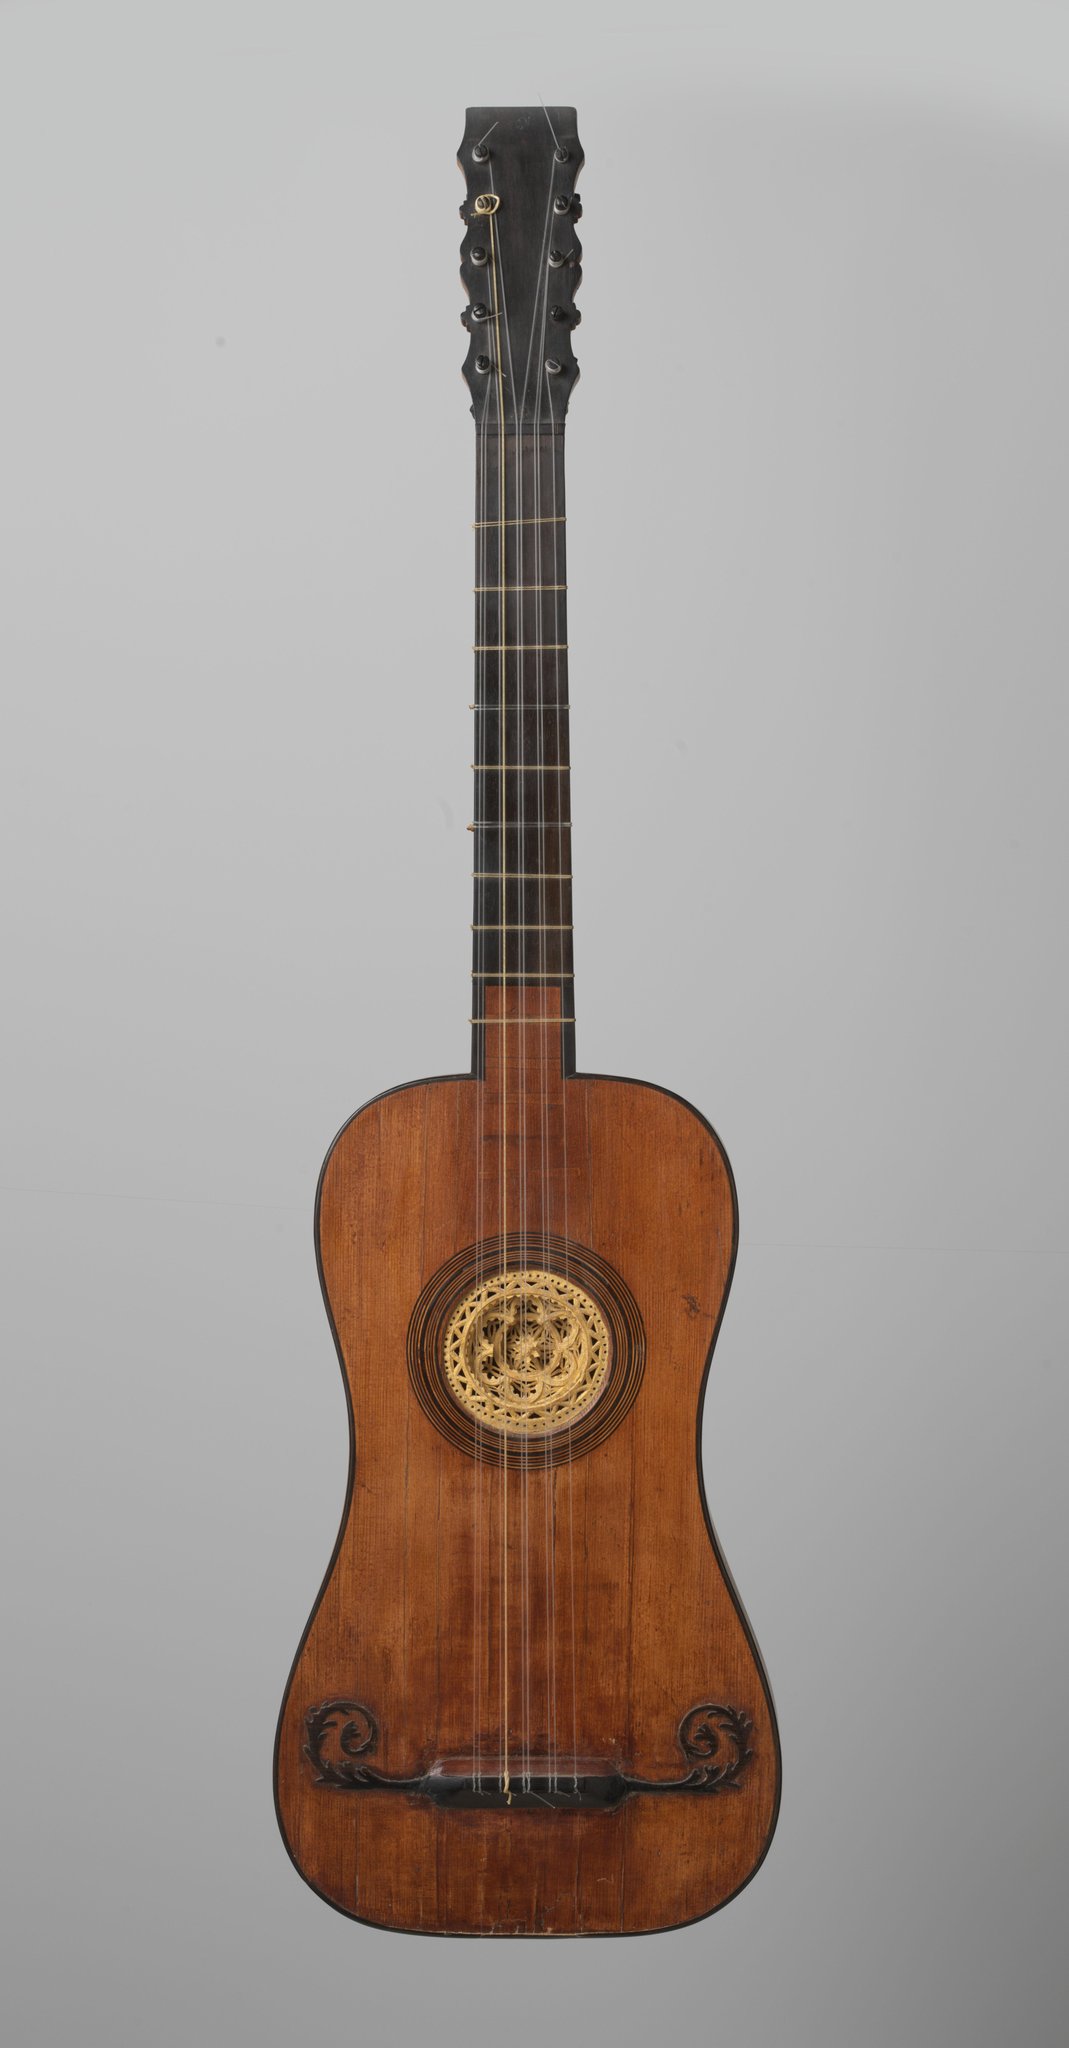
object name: stringed instrument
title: Guitar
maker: pierre louvet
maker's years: -1784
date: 1763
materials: wood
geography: paris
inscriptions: label: ‘'Louvet a Paris 1763'’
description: This five-course guitar presents a two-piece front of medium grain spruce with ebonised bridge and moustaches. The original rose is missing. The back (in two pieces) and ribs are maple. The centre of back is striped with a line of ebony. An ivory turned ivory button for the shoulder strap is set into the bottom block. The label reads 'Louvet a Paris 1763'.